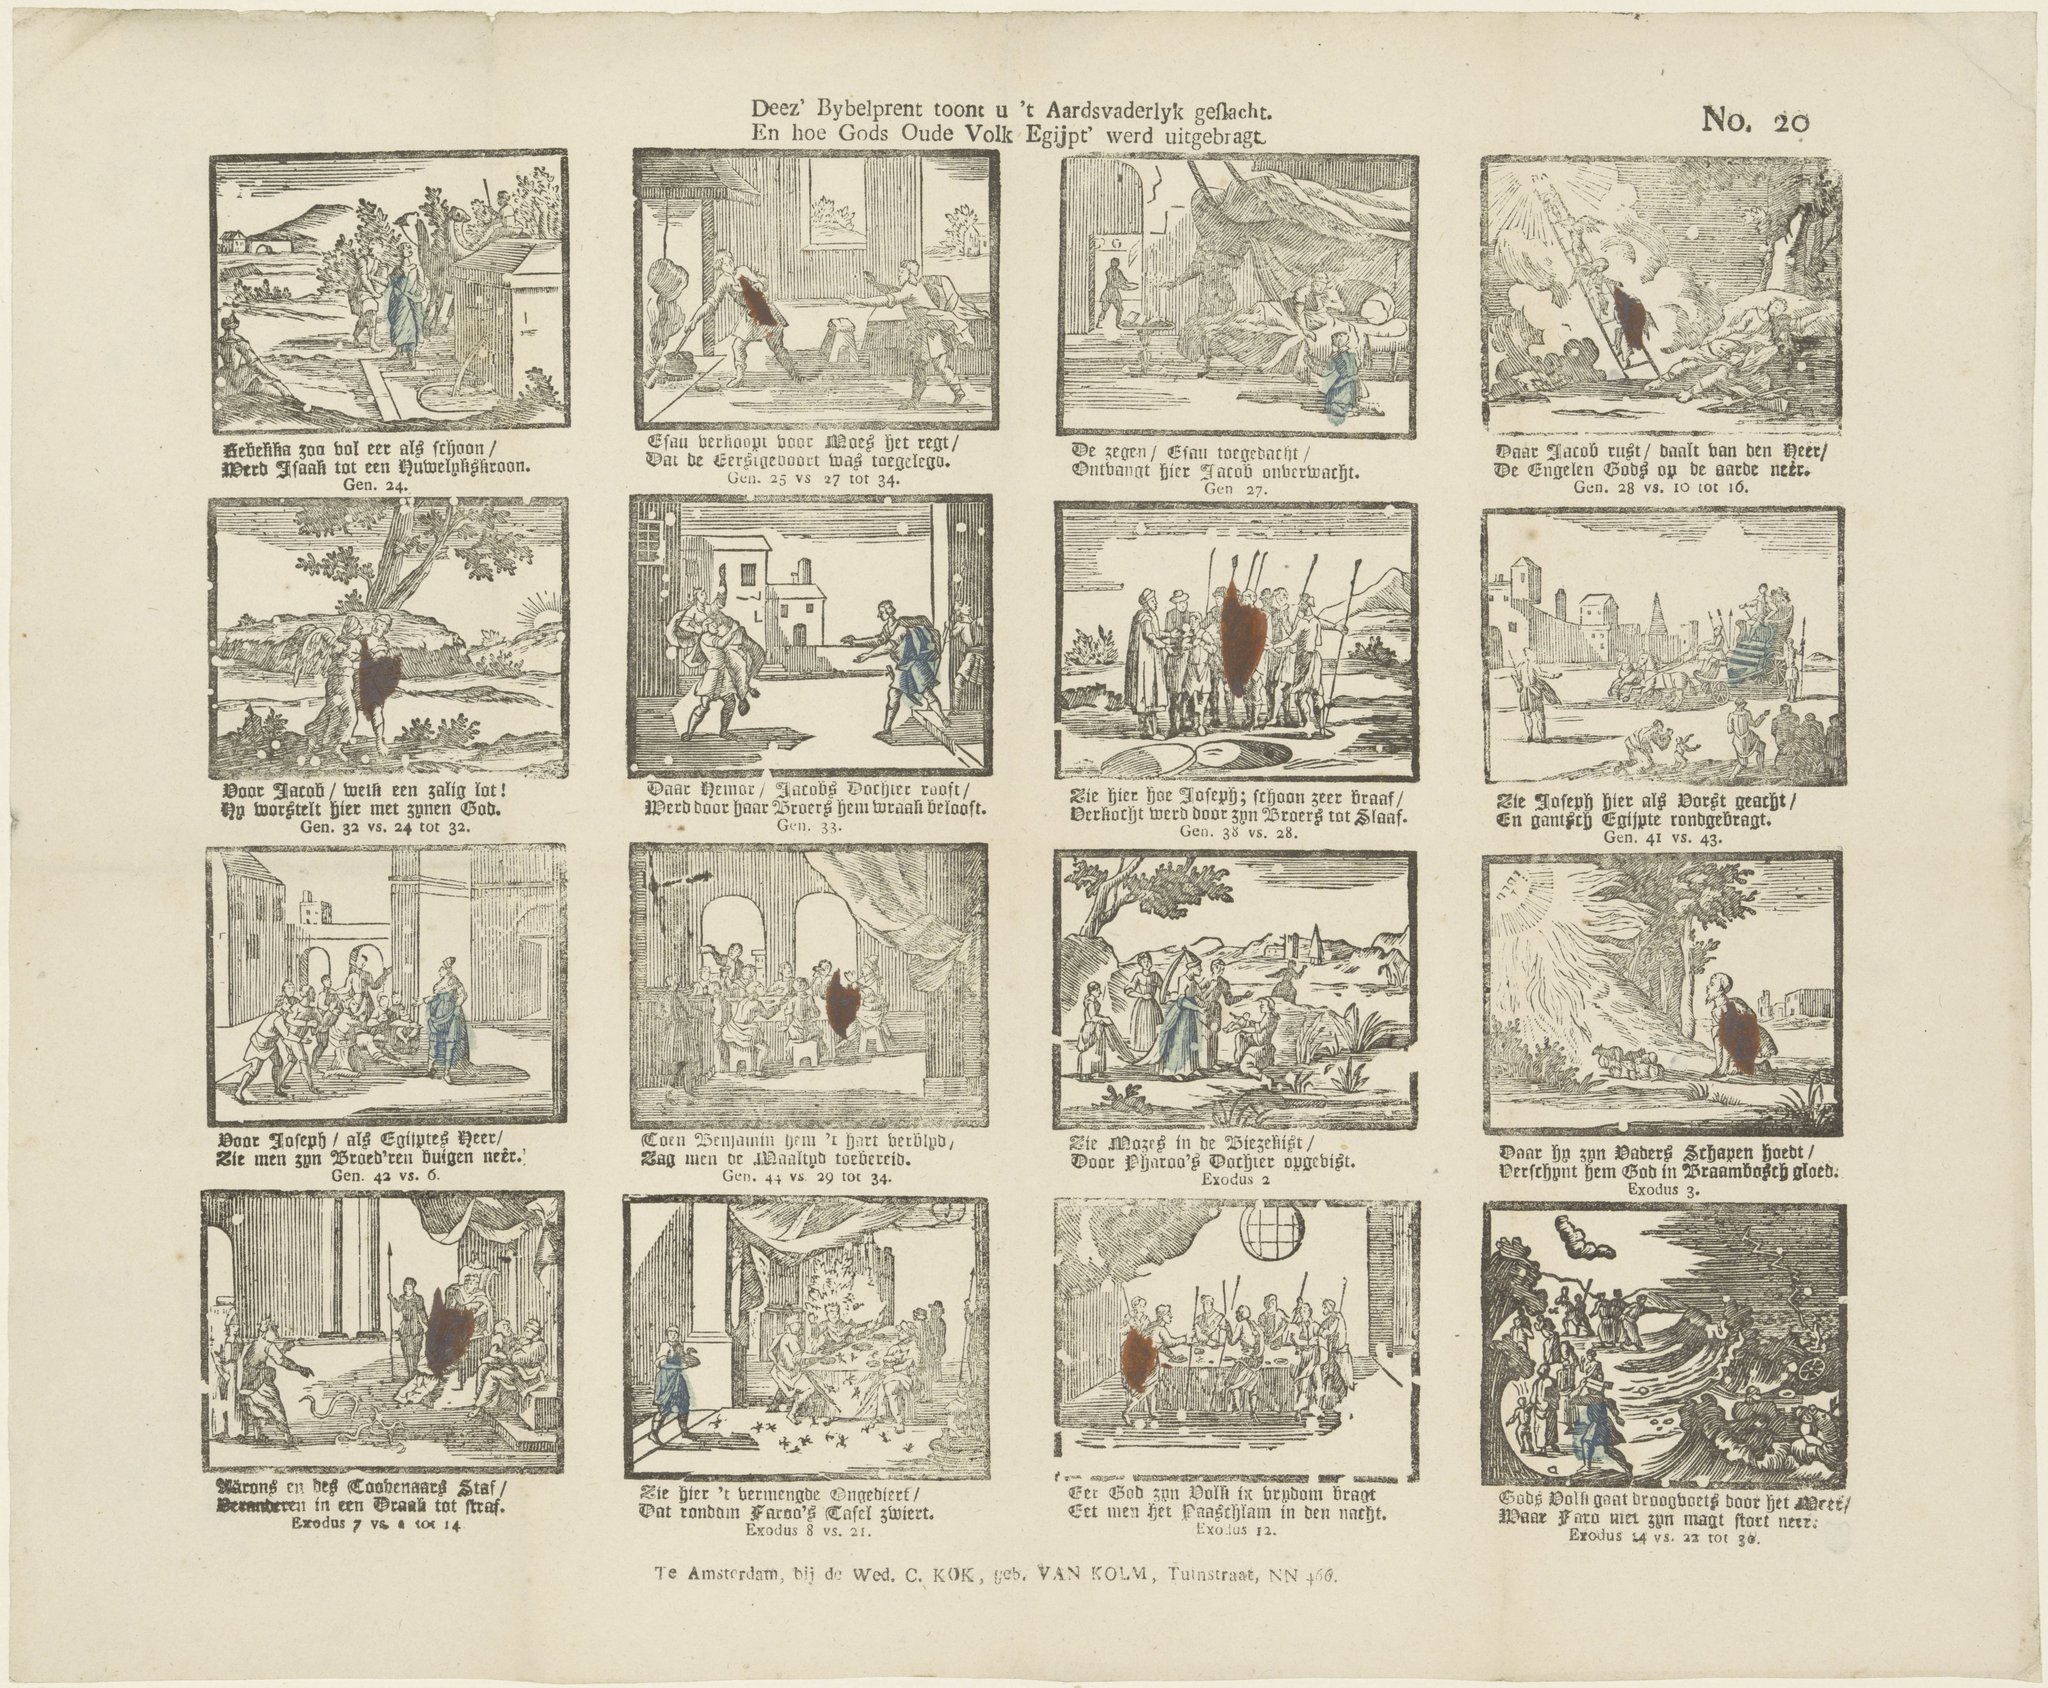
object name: print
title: Deez' bybelprent toont u 't aardsvaderlyk geslacht. / En hoe Gods oude volk Egijpt' werd uitgebragt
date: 1842-1866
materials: paper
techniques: colour, letterpress printing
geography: amsterdam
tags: moses is pulled out of the water by the servants, old testament, the dream of jacob: while sleeping on the ground with a stone for pillow jacob sees a ladder reaching from earth to heaven with angels going up and down; usually with god at the top of the ladder, passage through the red sea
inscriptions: collector's mark: Lugt 2760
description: Blad met 16 voorstellingen van verhalen uit het Oude Testament, waaronder Jakobs droom, Mozes die wordt gevonden en de doortocht door de Rode zee. Onder elke voorstelling een tweeregelig vers en een verwijzing naar de bijbehorende Bijbeltekst. Genummerd rechtsboven: No. 20.